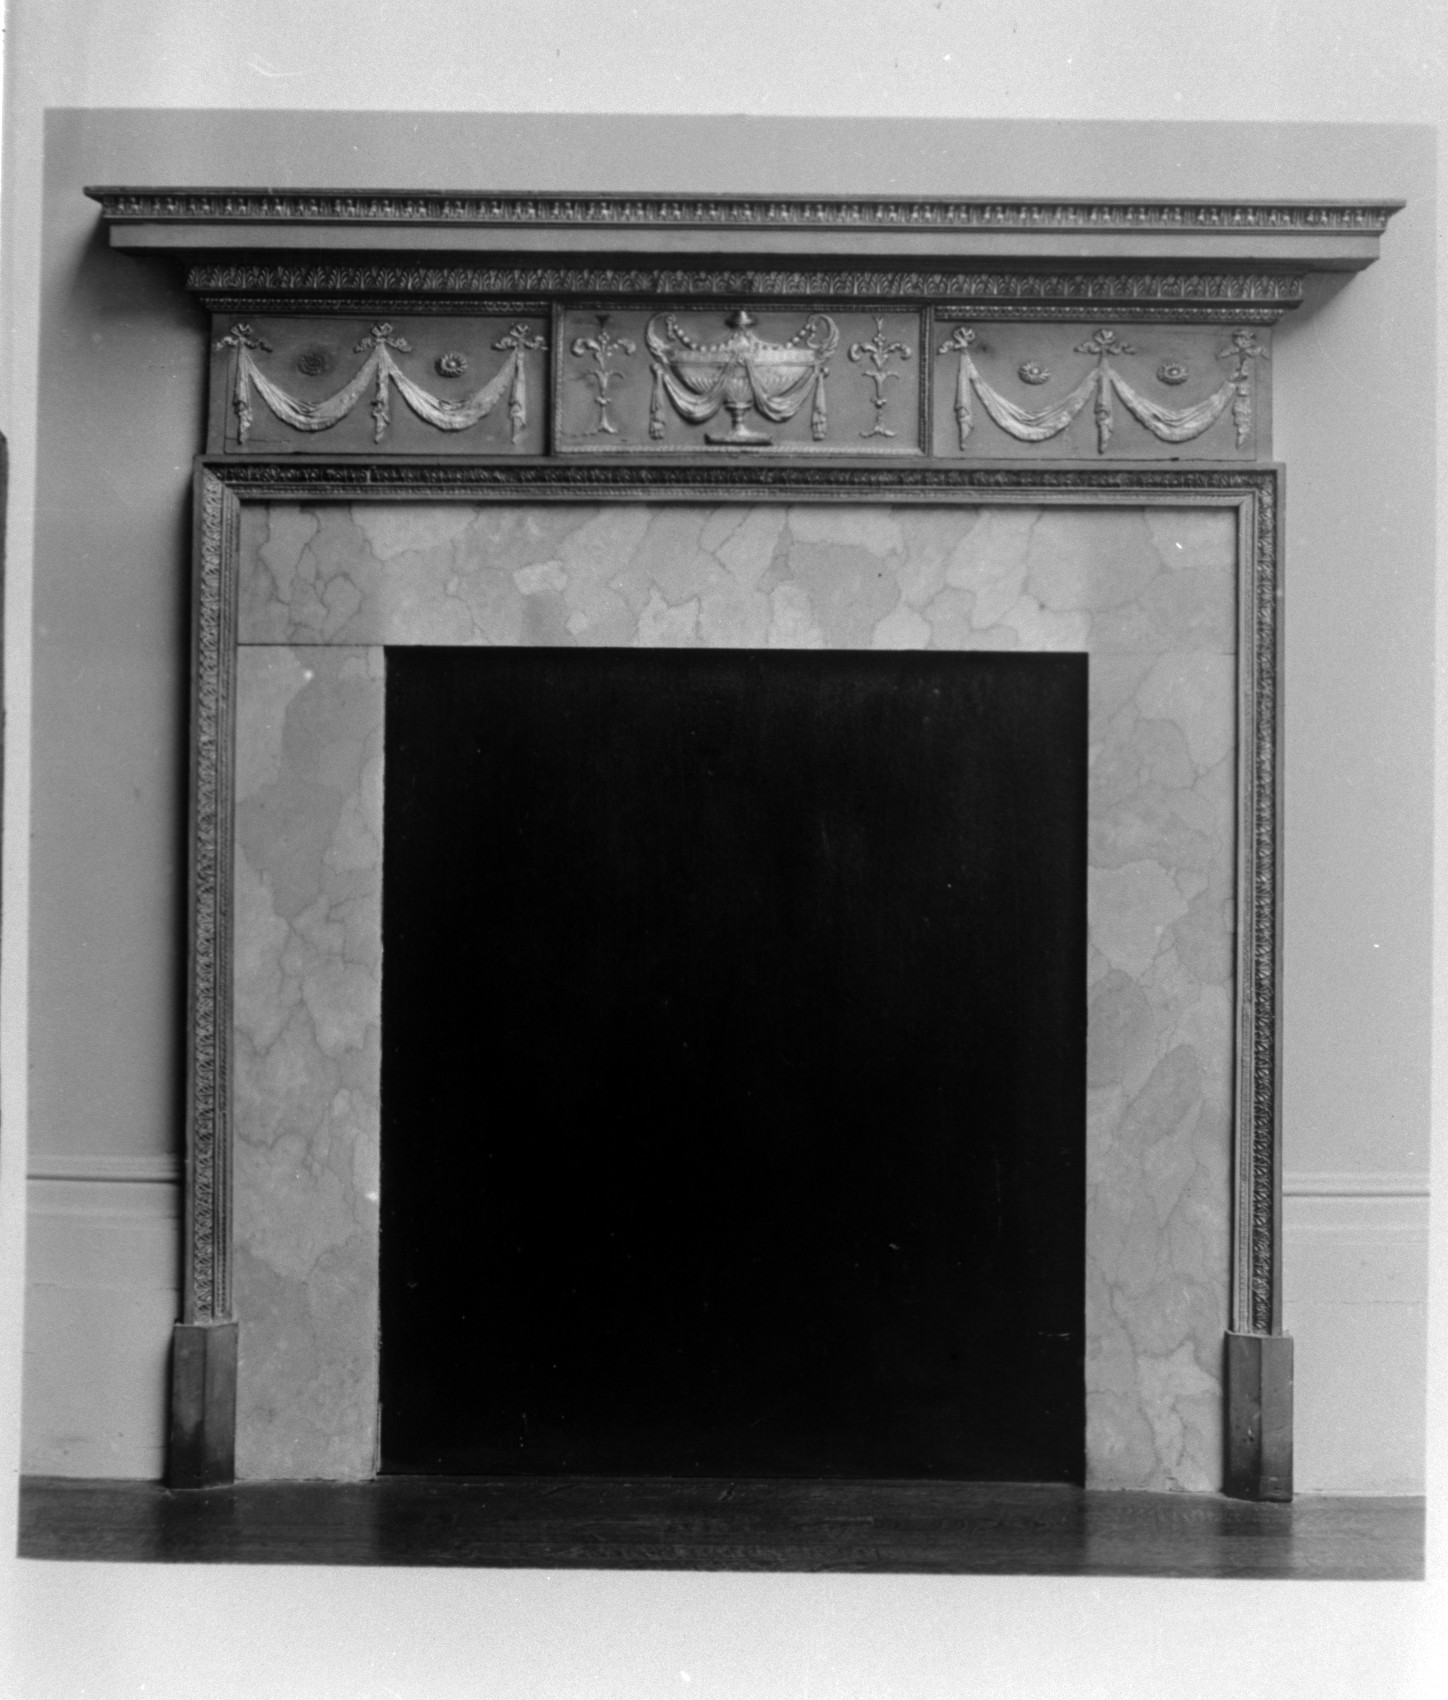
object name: mantelpiece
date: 1770-1780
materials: metal, wood